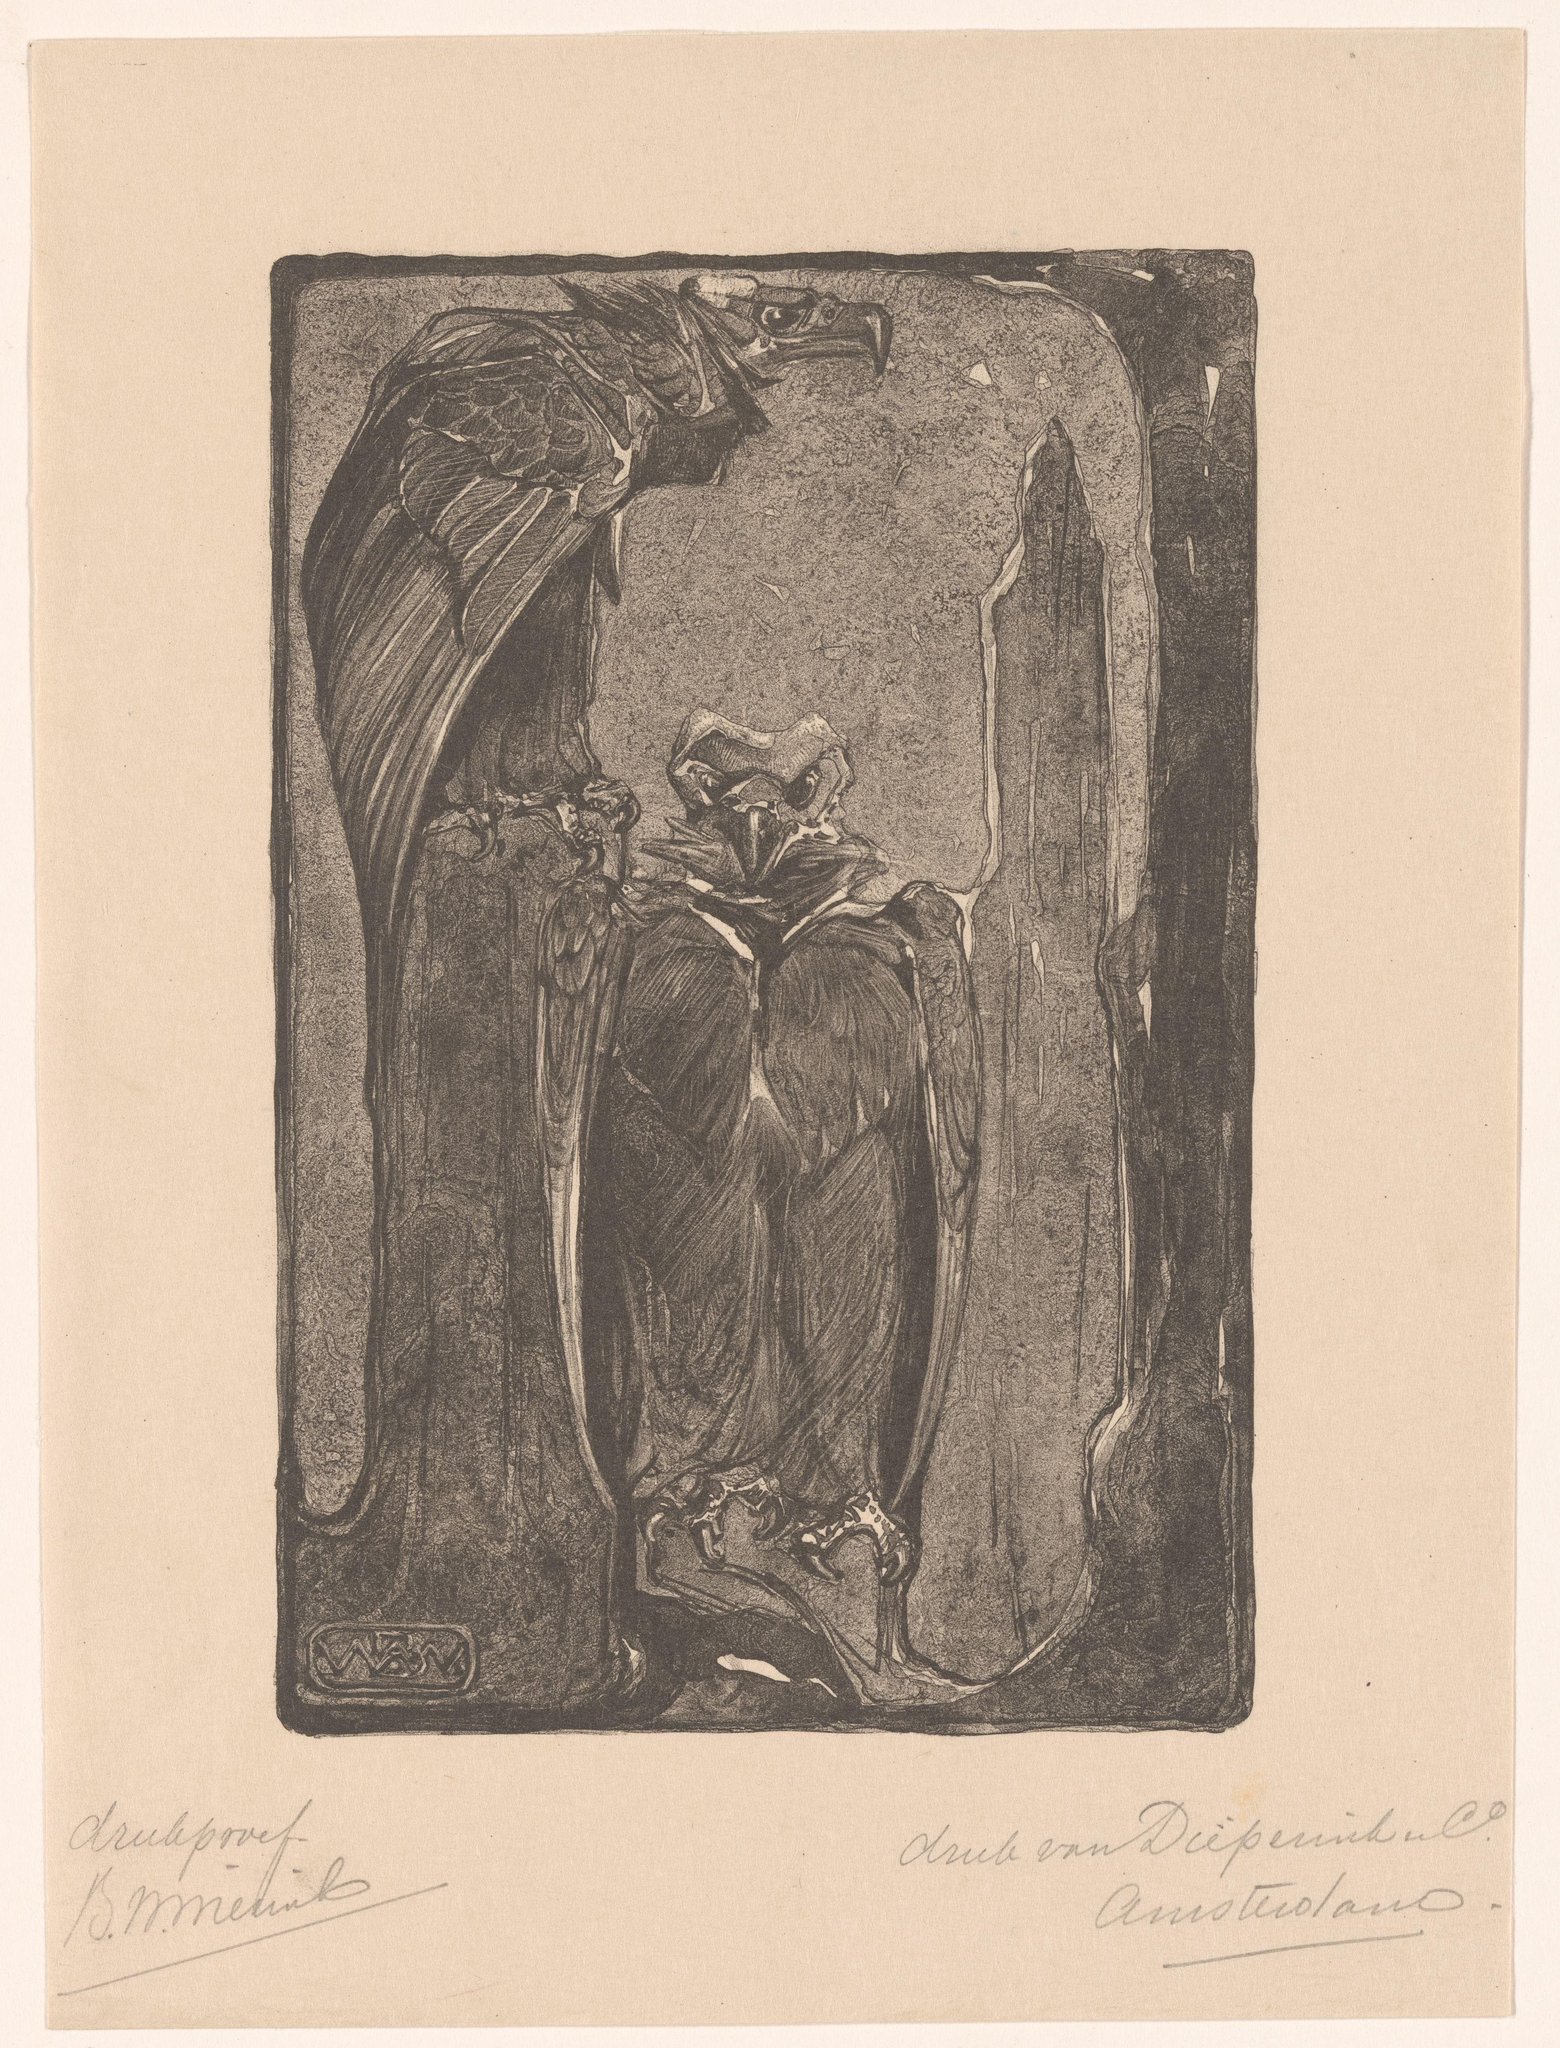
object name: print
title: Monniksgieren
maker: bernard willem wierink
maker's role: draughtsman, print maker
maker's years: 1856-1939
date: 1915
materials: paper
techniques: lithograph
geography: amsterdam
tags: predatory birds: vulture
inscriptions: collector's mark: Lugt 2233